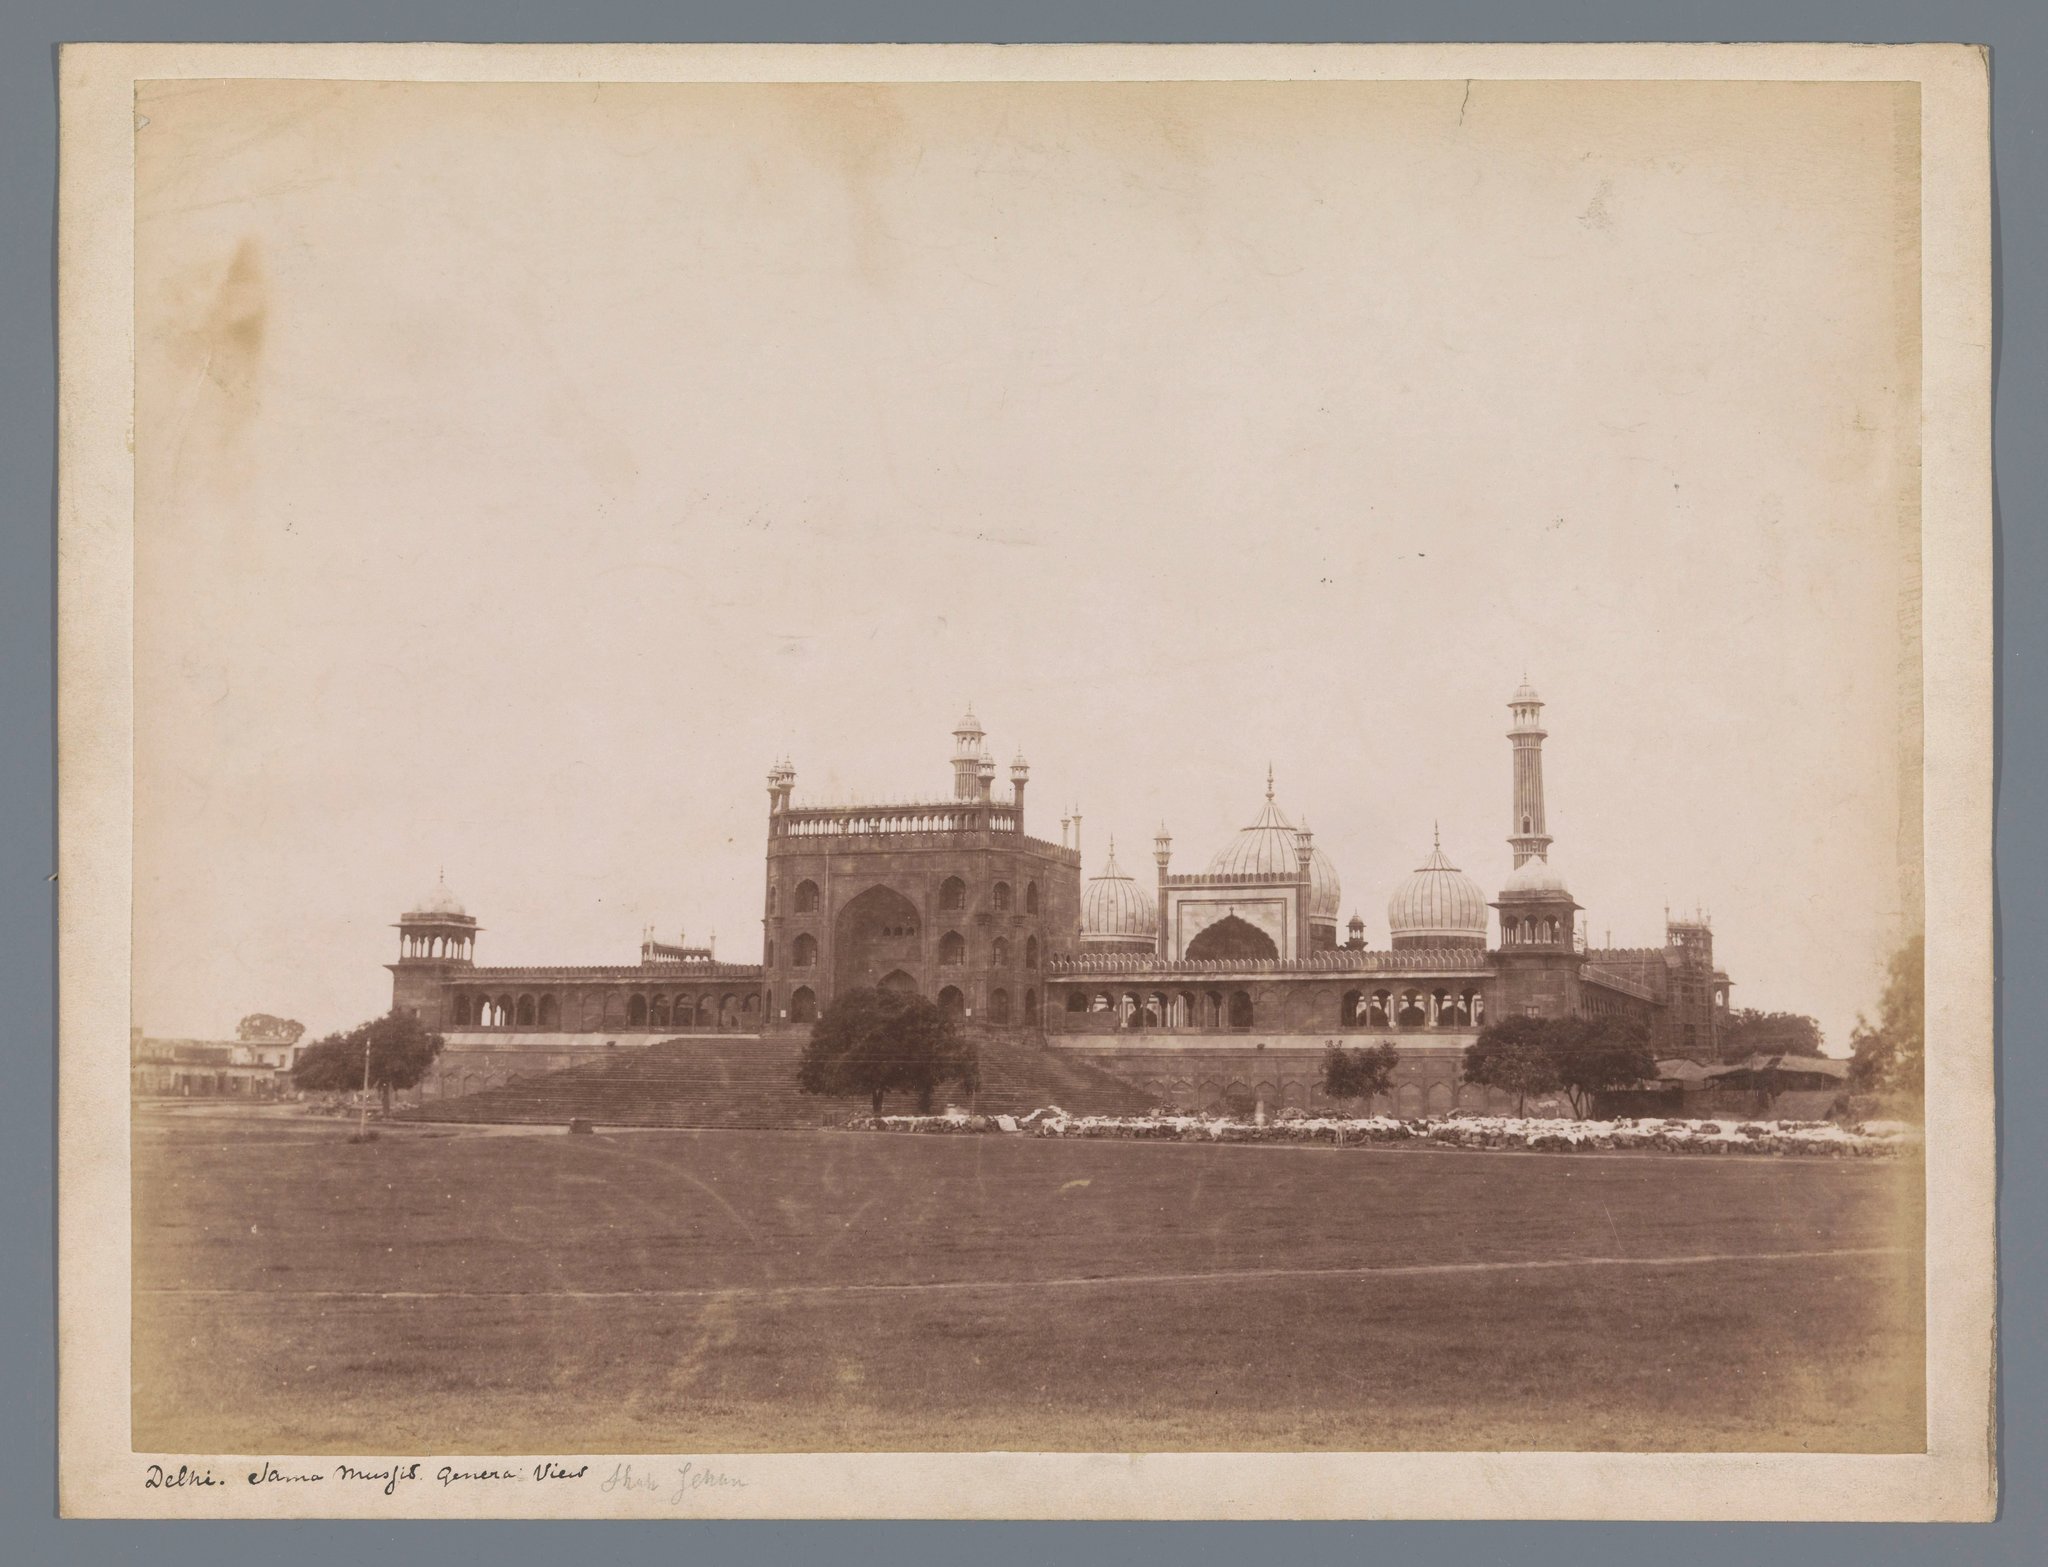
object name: photograph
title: View of the Jama Masjid in Delhi, India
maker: Anonymous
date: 1860-1890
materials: cardboard, paper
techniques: albumen print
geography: delhi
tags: temple, shrine ~ islam, mohammedanism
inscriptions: title: ‘Delhi. Jama Masjid. General View’, inscription: ‘Shah Jehan’, number: ‘65’